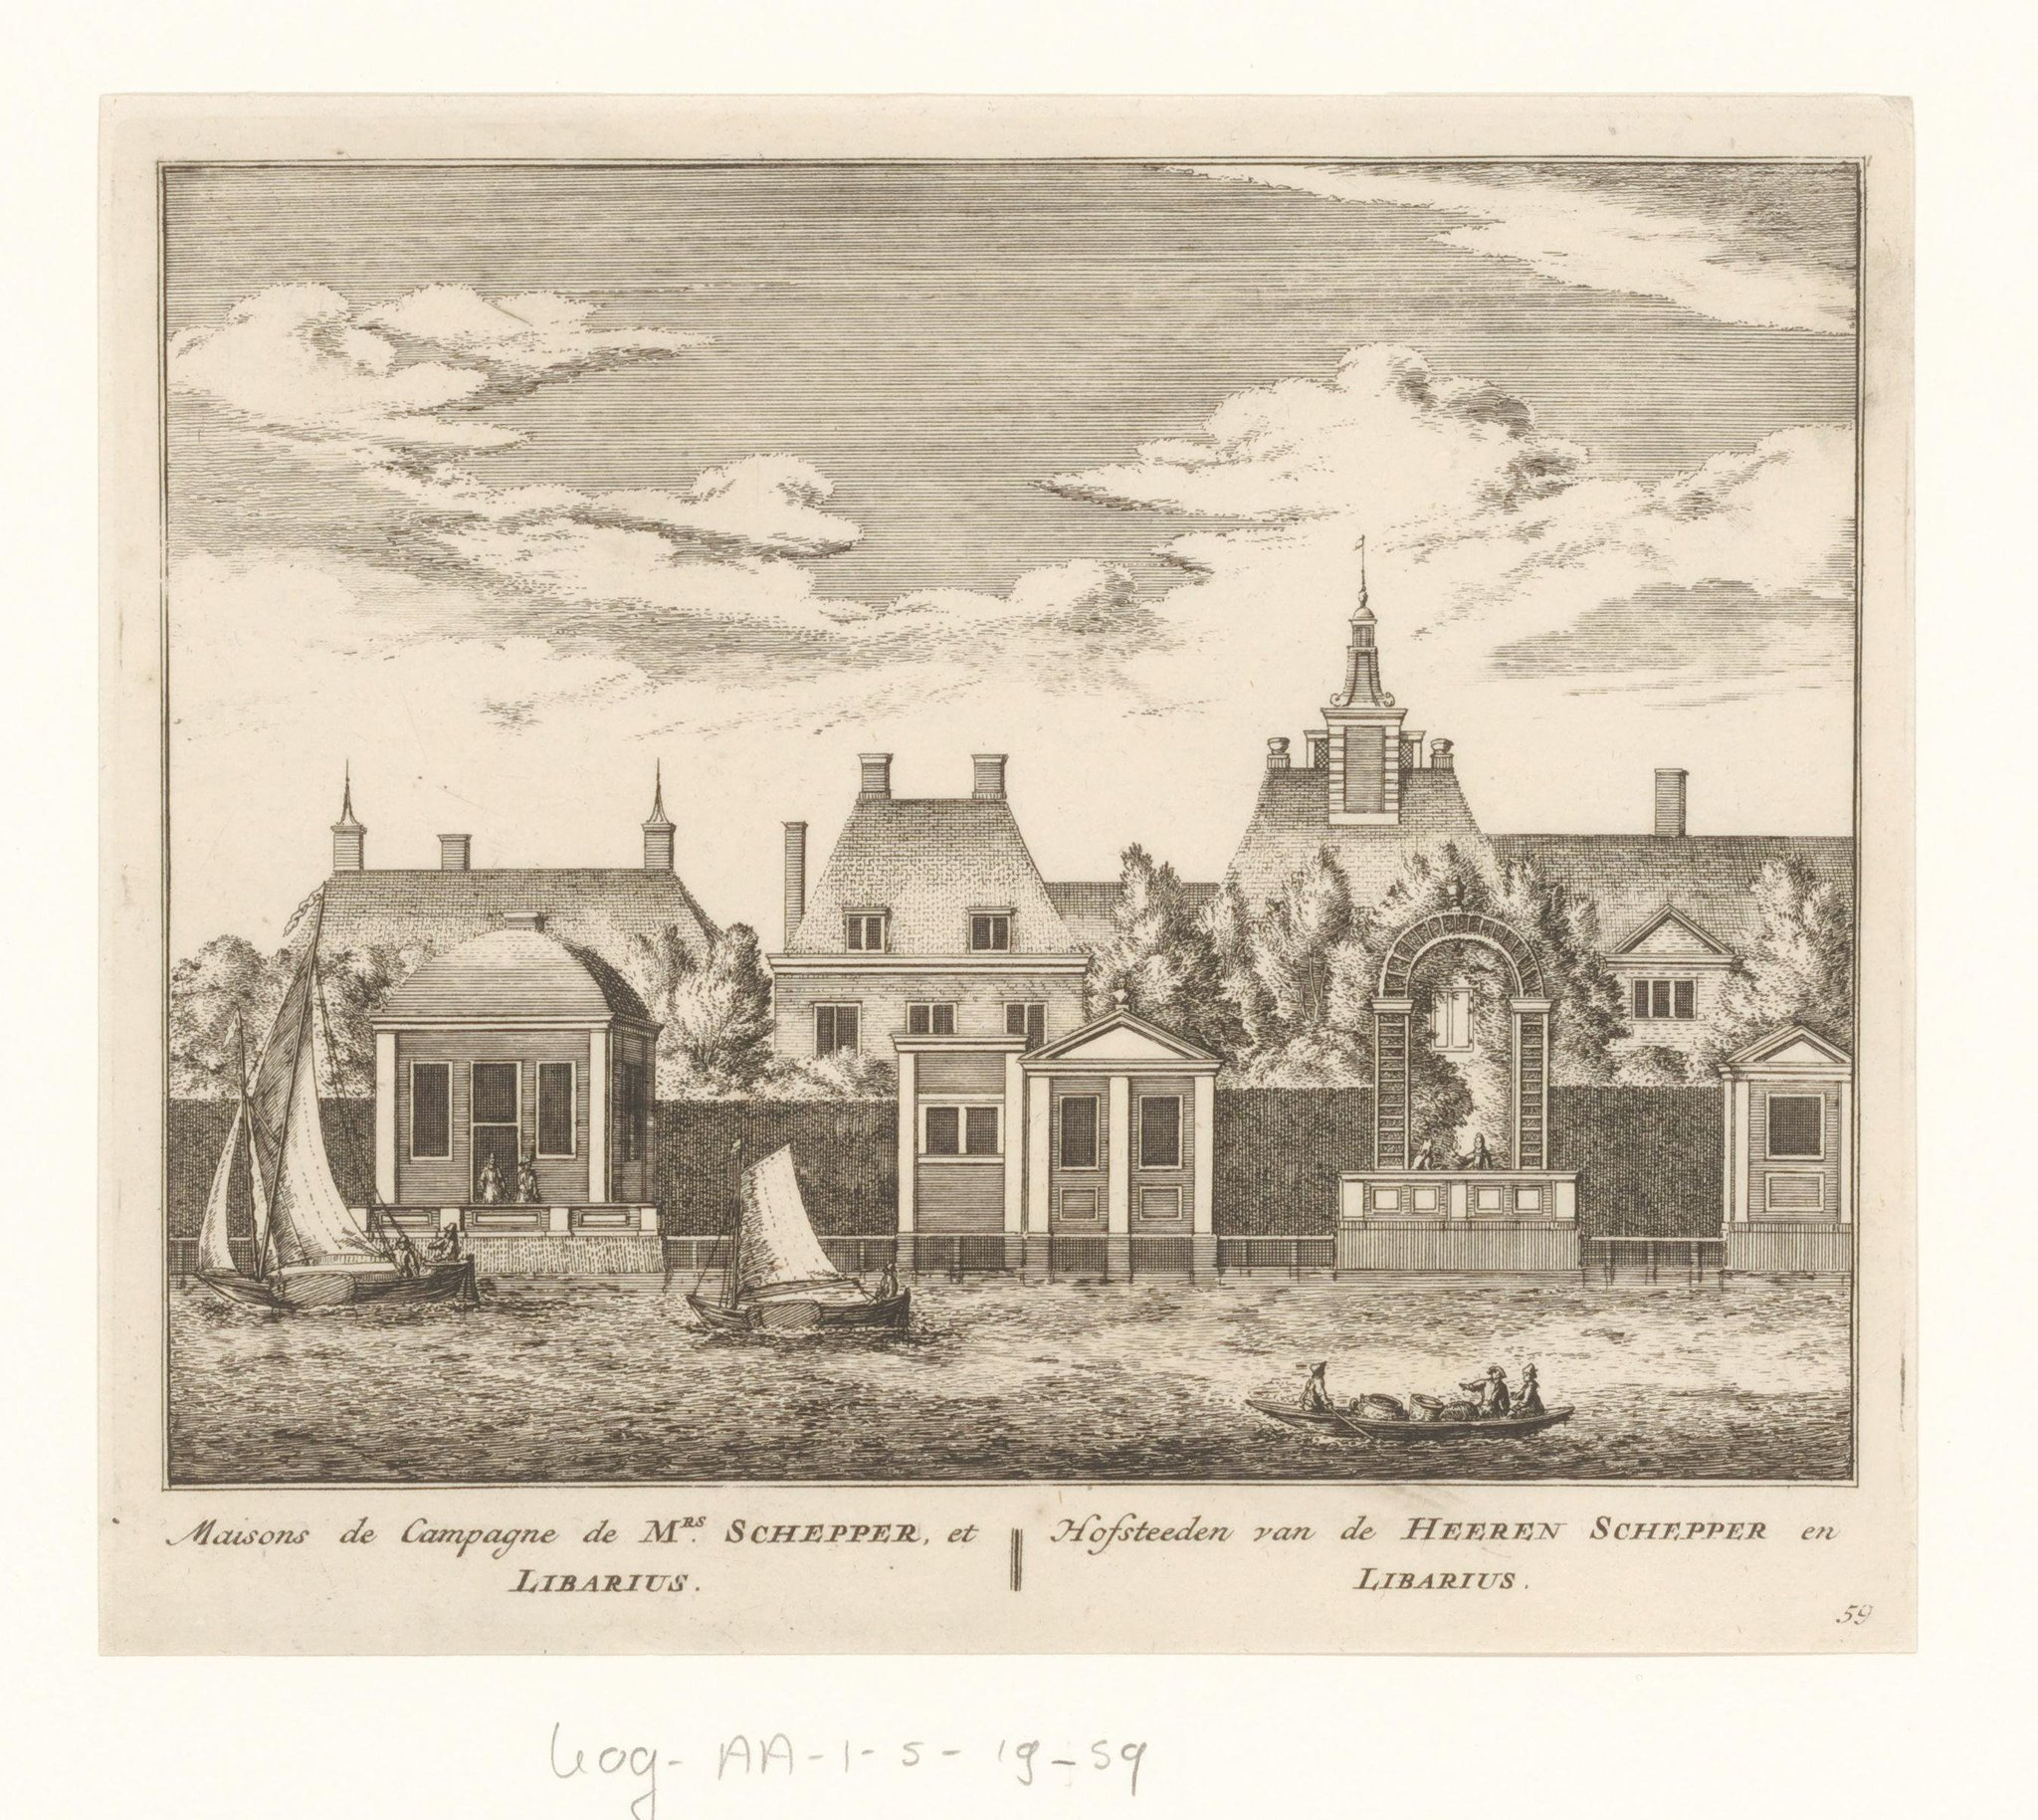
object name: print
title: Hofsteeden van de Heeren Schepper en Libarius / Maisons de Campagne de Mrs. Schepper, et Libarius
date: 1730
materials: paper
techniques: etching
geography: amsterdam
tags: sailing-ship, sailing-boat, city-view in general; 'veduta', river, rural housing, e.g. country-house, villa, cottage, boat propelled by man or animal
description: Prent waarschijnlijk uit: Tijsens, Gijsbert. Hollands Arcadia, of de vermaarde rivier den Amstel (...) naar 't léven getekend en in 't ligt gebragt door Abraham Rademaker (...). Amsterdam: Leonardus Schenk, 1730.